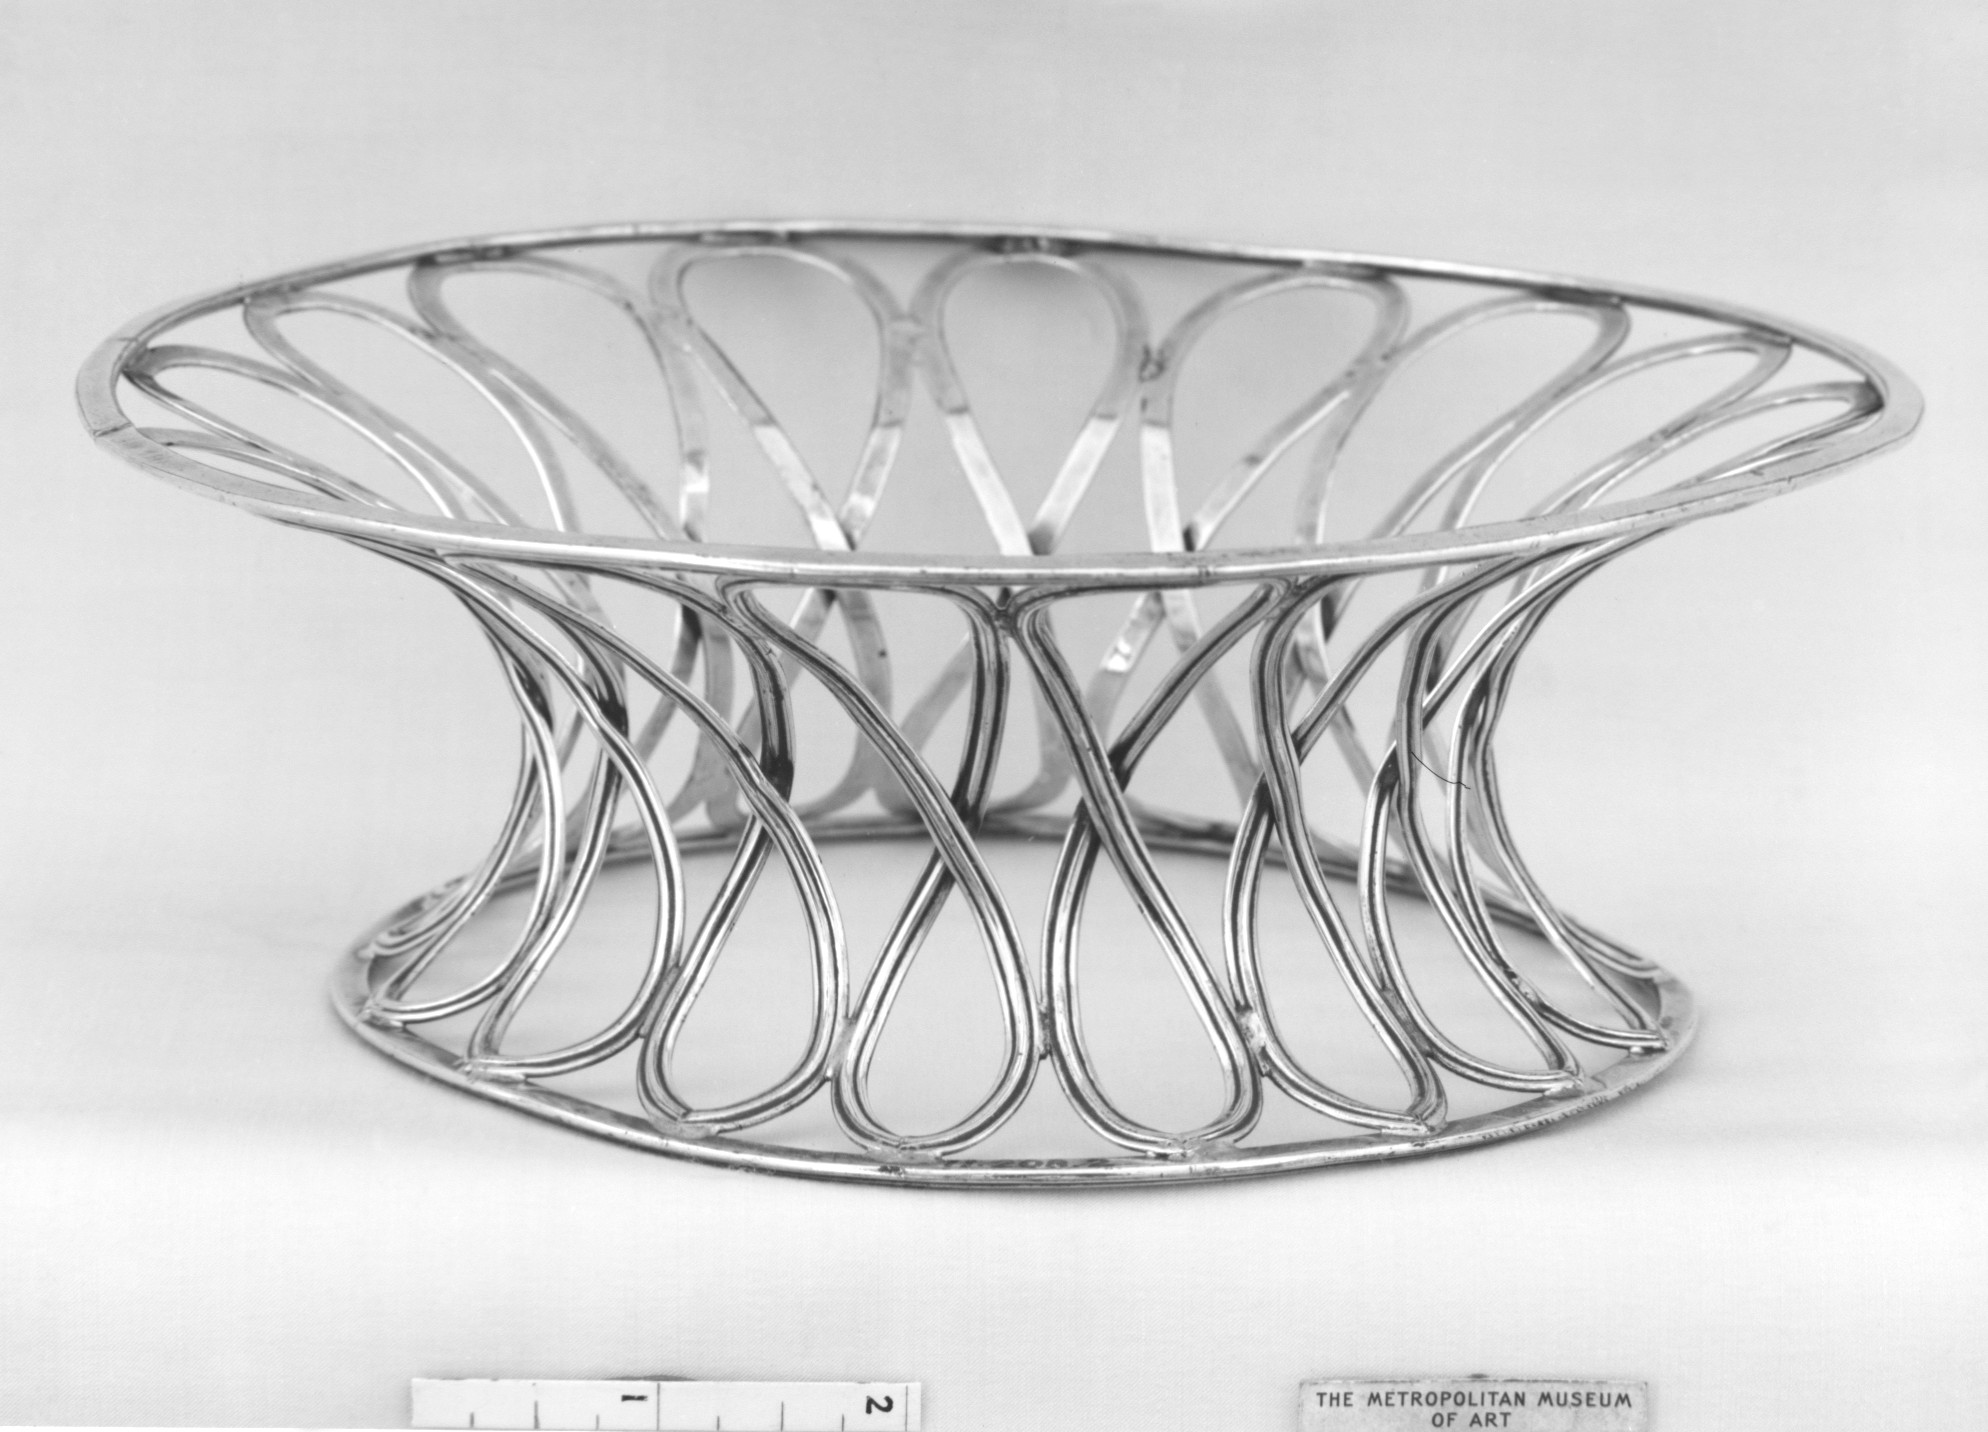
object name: potato ring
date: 1790-1805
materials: metal